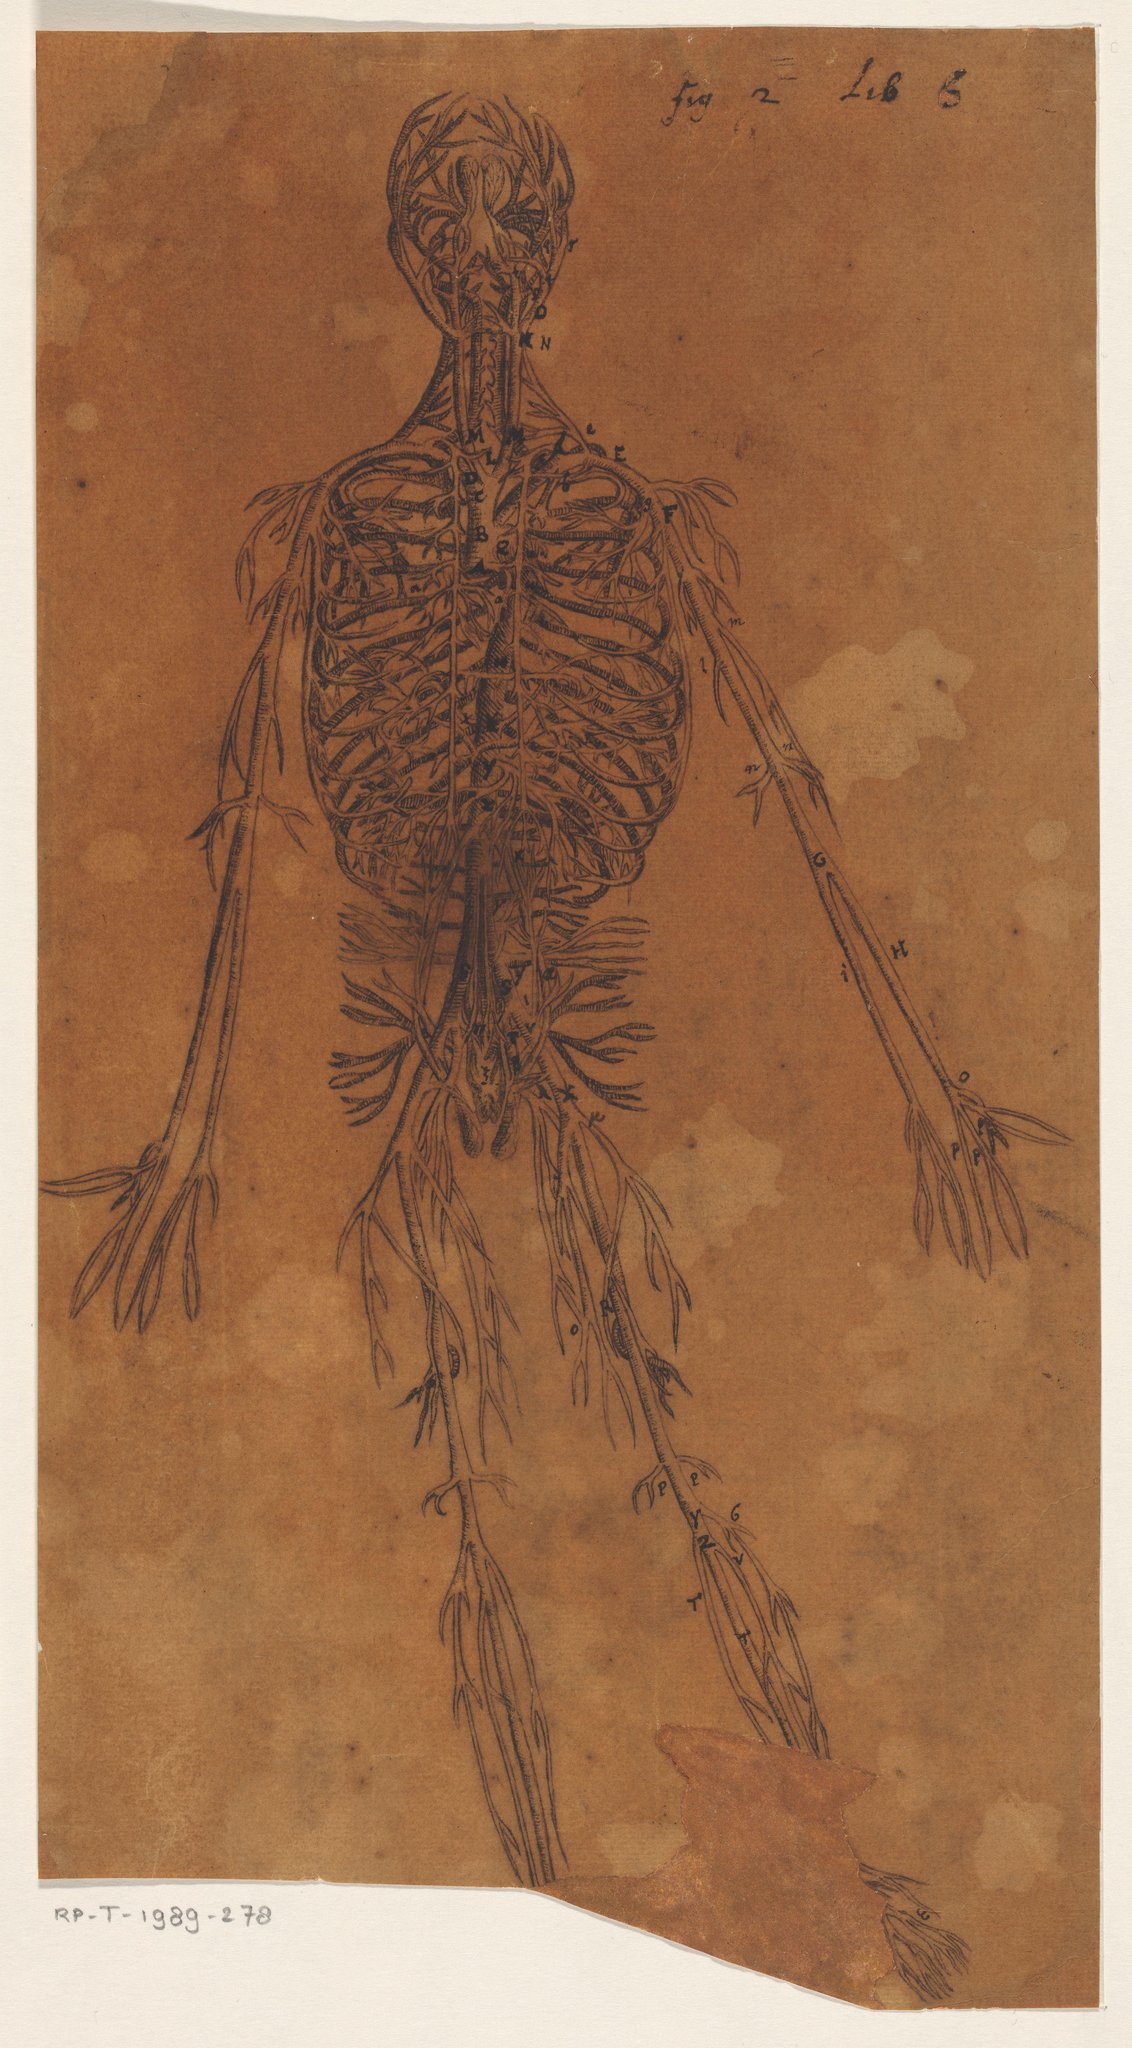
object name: drawing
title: Anatomische studie van de slagaders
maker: Anonymous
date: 1630-1649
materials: ink, paper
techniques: pen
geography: low countries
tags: arteries, anatomical model of the arteries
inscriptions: collector's mark: Lugt 2228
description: De tekening en de letters die de verschillende onderdelen aanduiden komen overeen met een prent uit: Spiegel, Adriaan van den, en Daniel Bucretius. De humani corporis fabrica libri decem. Venetië: s.n., 1627. Tekening zit in een omslag met meerdere anatomische tekeningen, genummerd RP-T-1989-256 en RP-T-1989-258 t/m RP-T-1989-289.